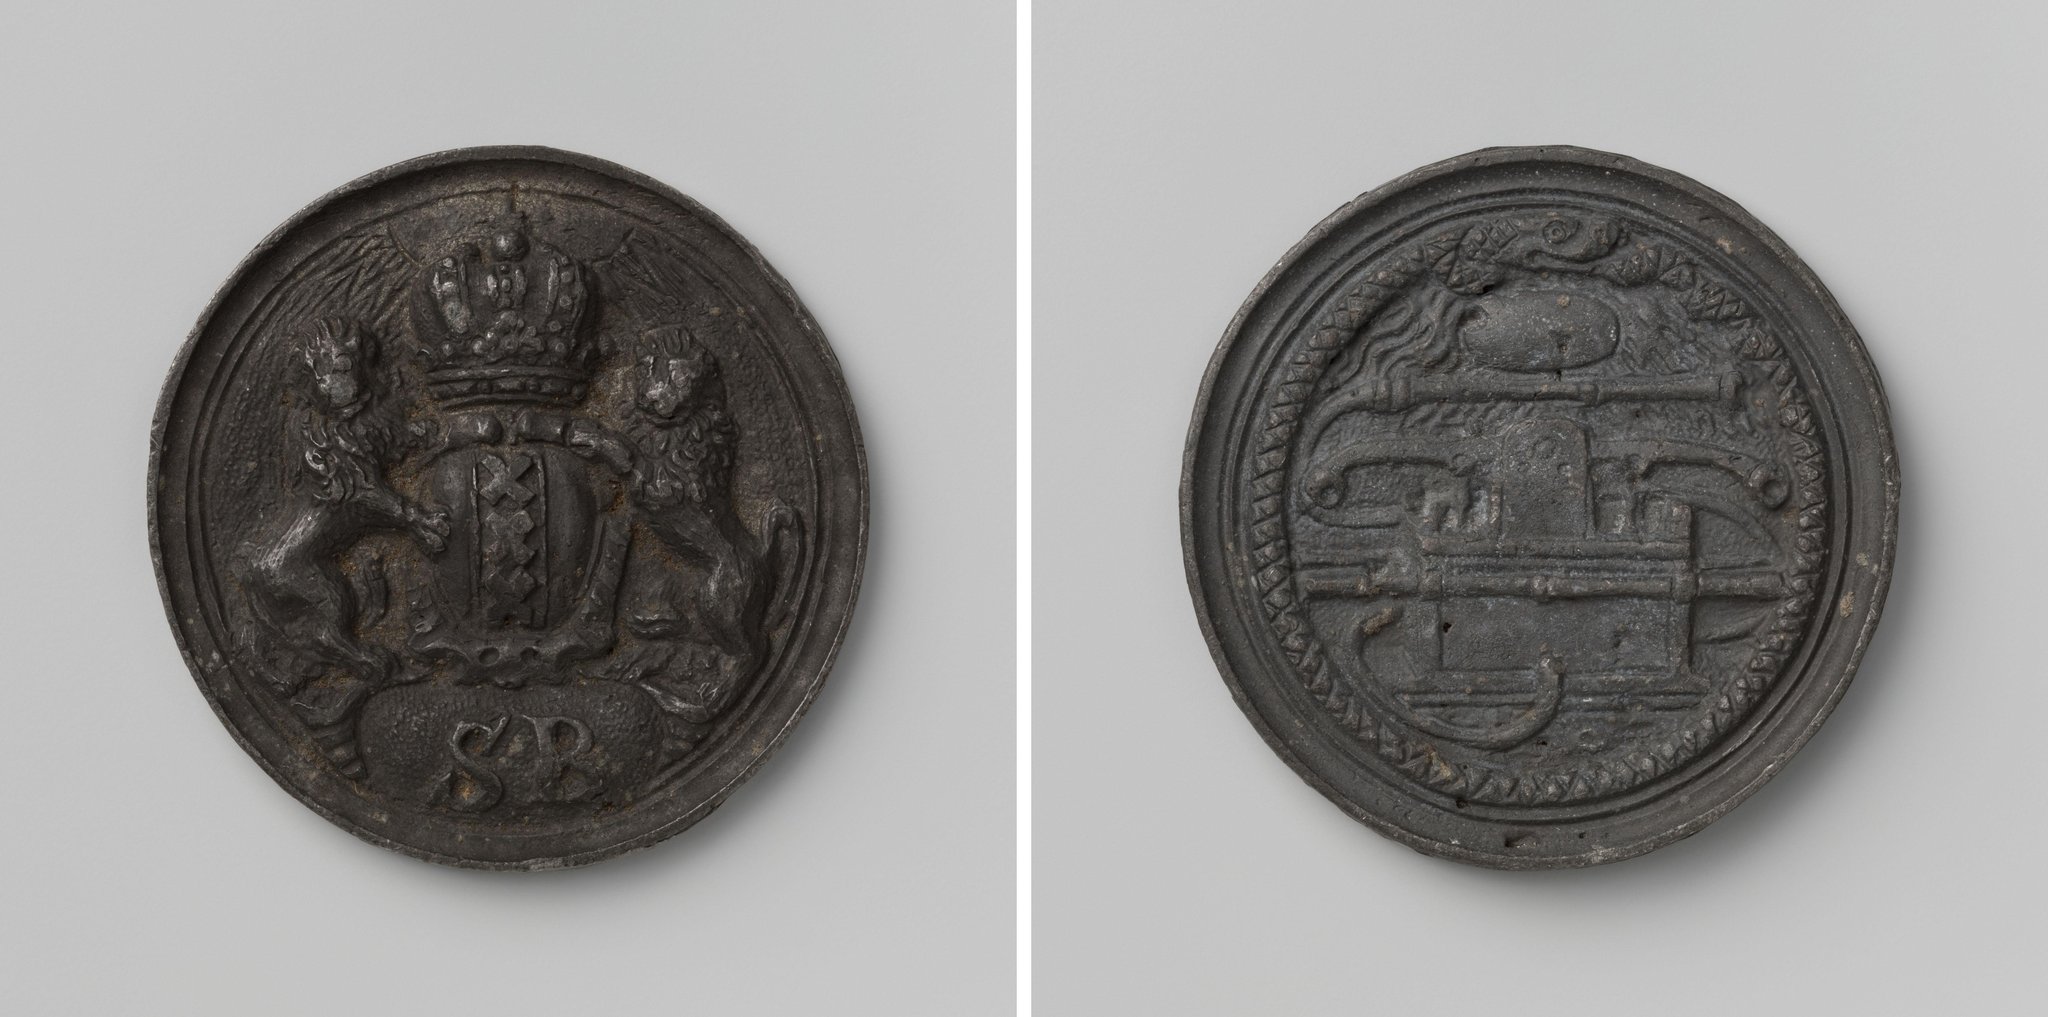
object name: medal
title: Amsterdam, brandspuitpenning van de wijk Schouwburg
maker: Anonymous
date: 1680-1800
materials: lead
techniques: casting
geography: amsterdam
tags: schouwburg (wijk)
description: Loden penning. Voorzijde: gekroond wapenschild, geflankeerd door twee leeuwen boven cartouche met opschrift S.B.. Keerzijde: brandspuit onder leeg cartouche binnen slangerond